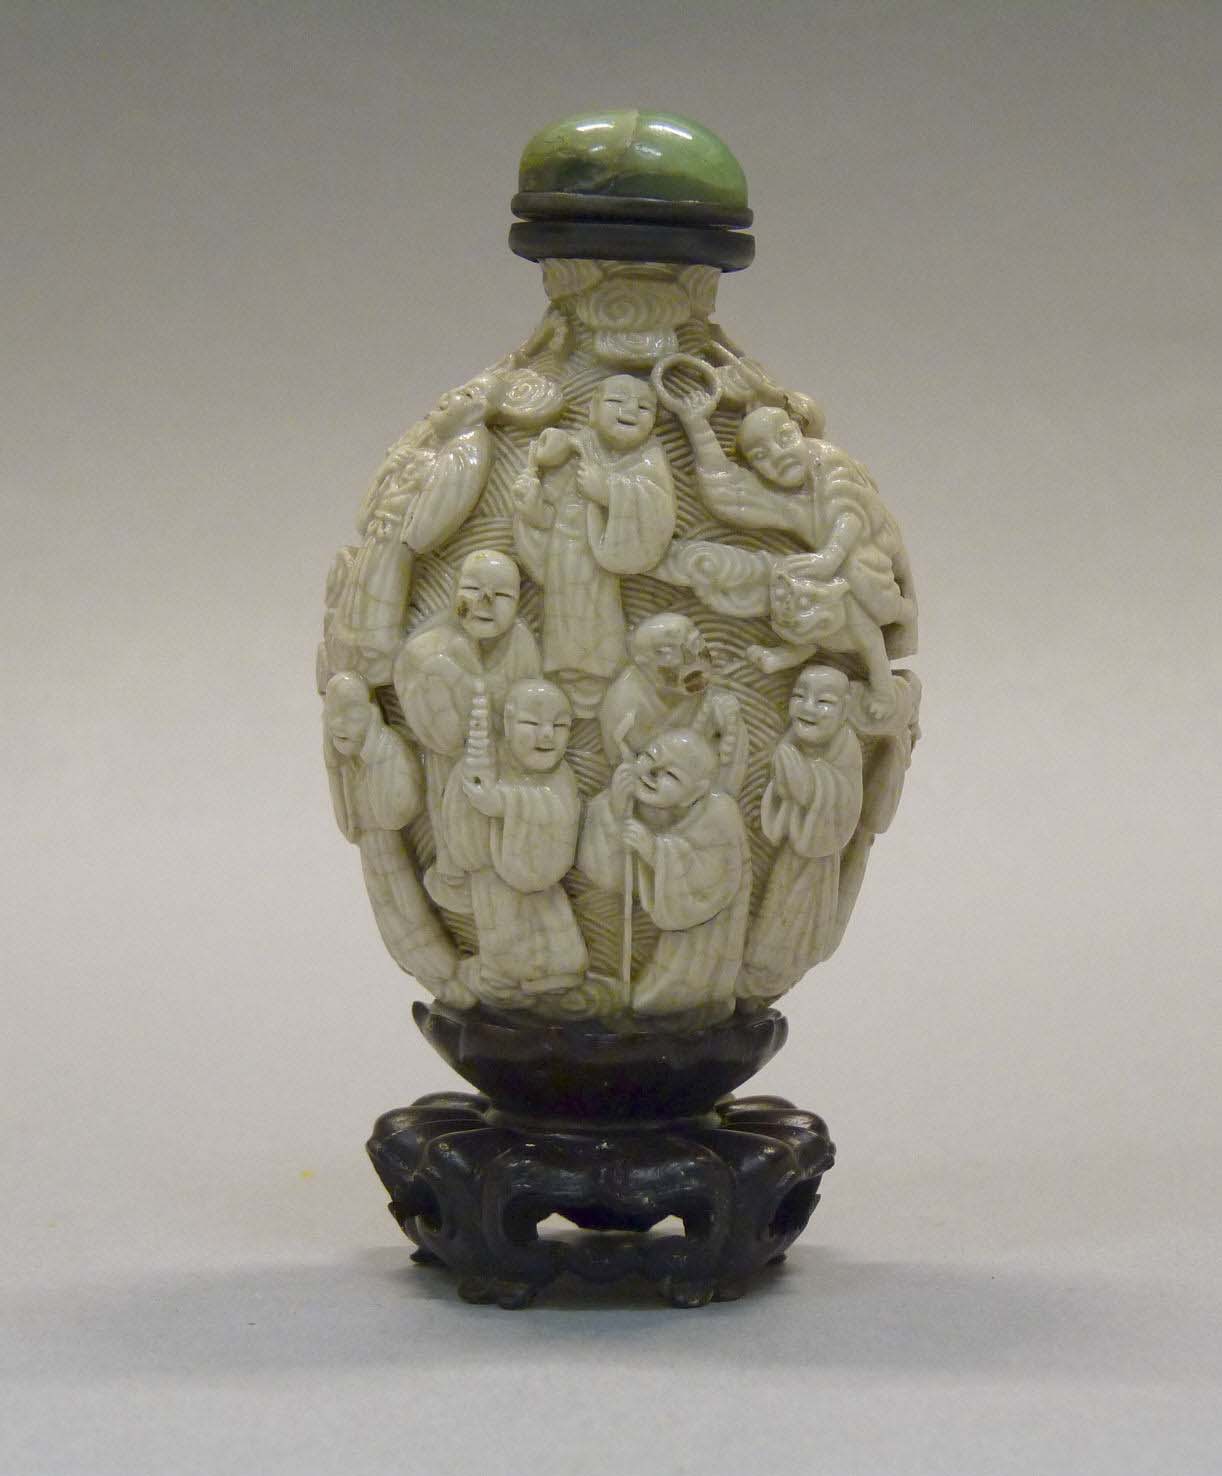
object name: snuff bottle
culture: chinese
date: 1736-1795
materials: jade, porcelain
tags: men